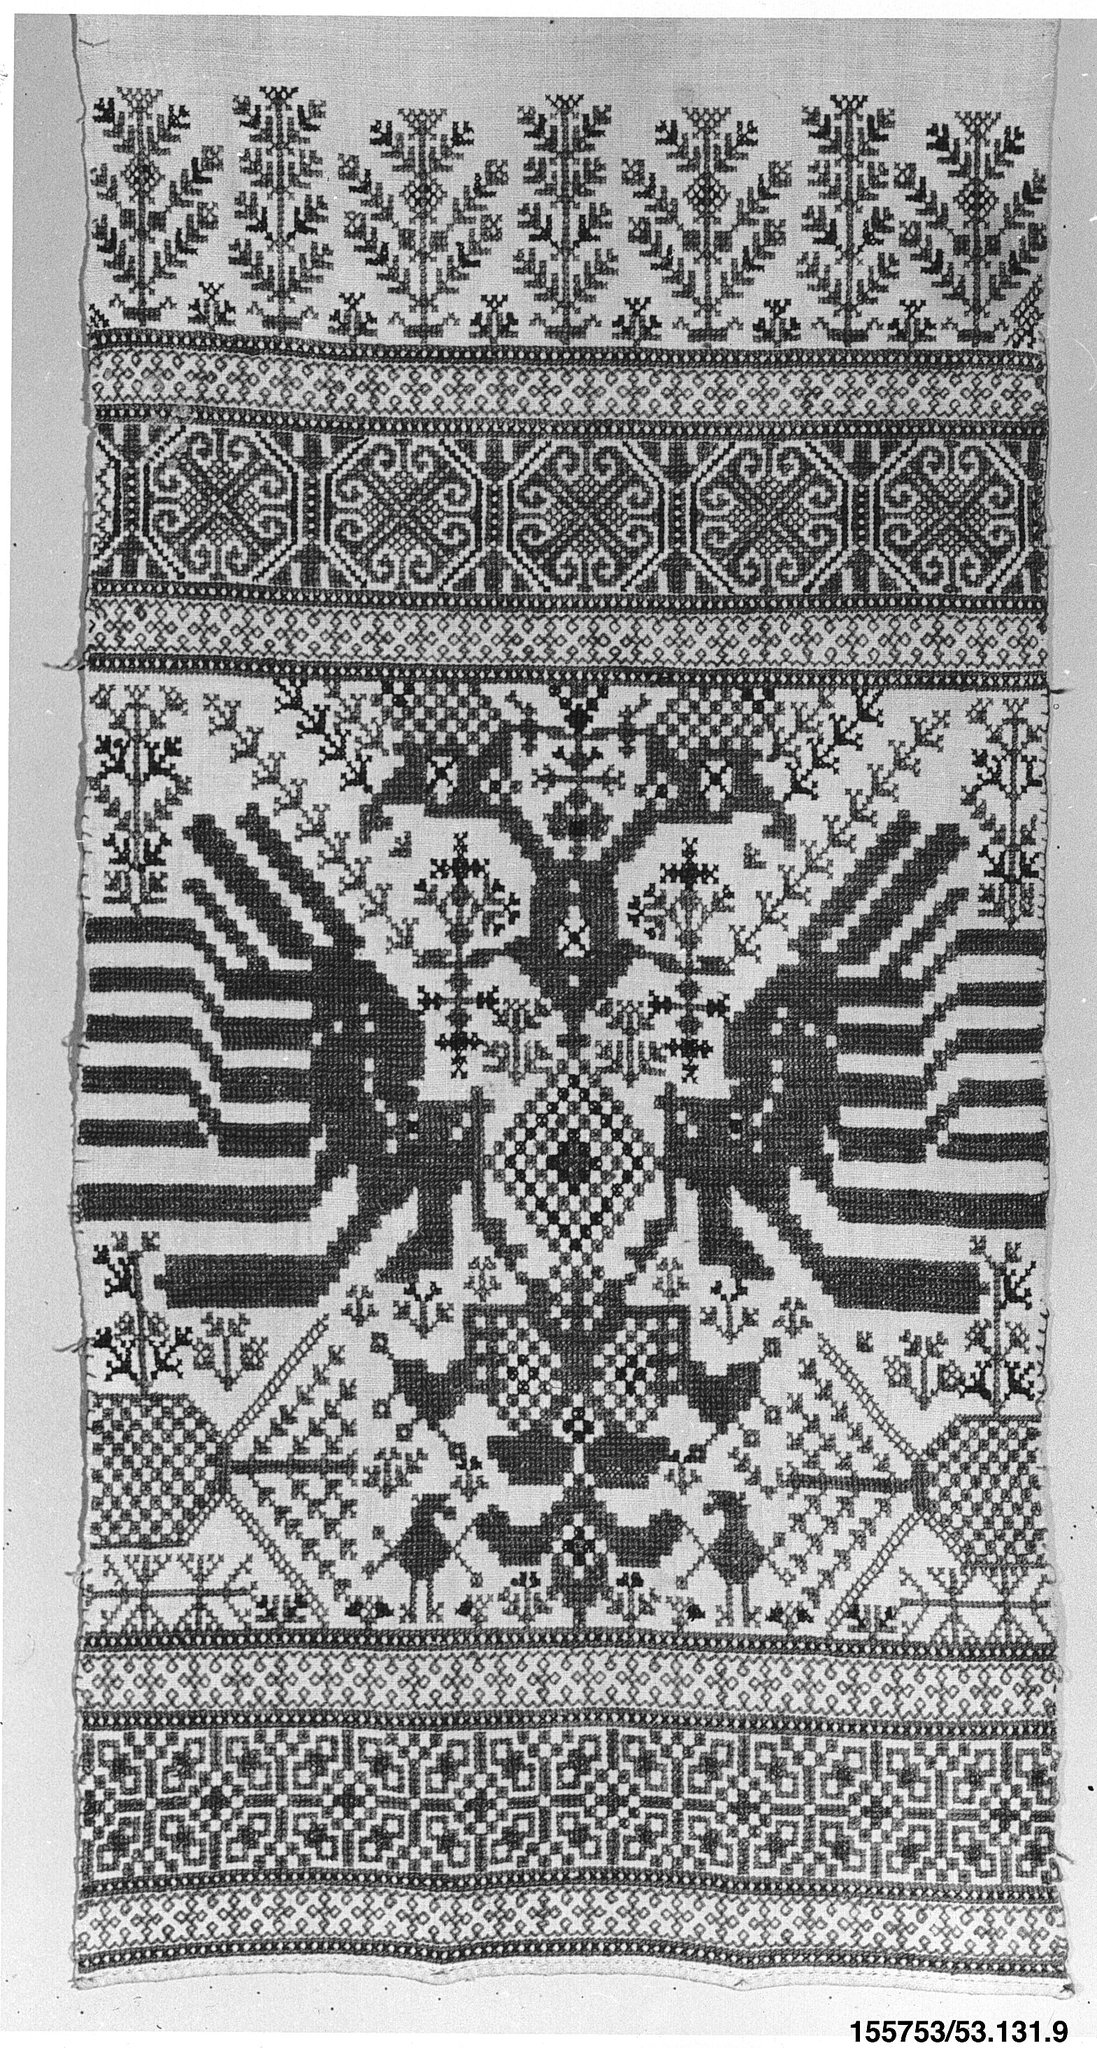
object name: towel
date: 1701-1800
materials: cotton, linen